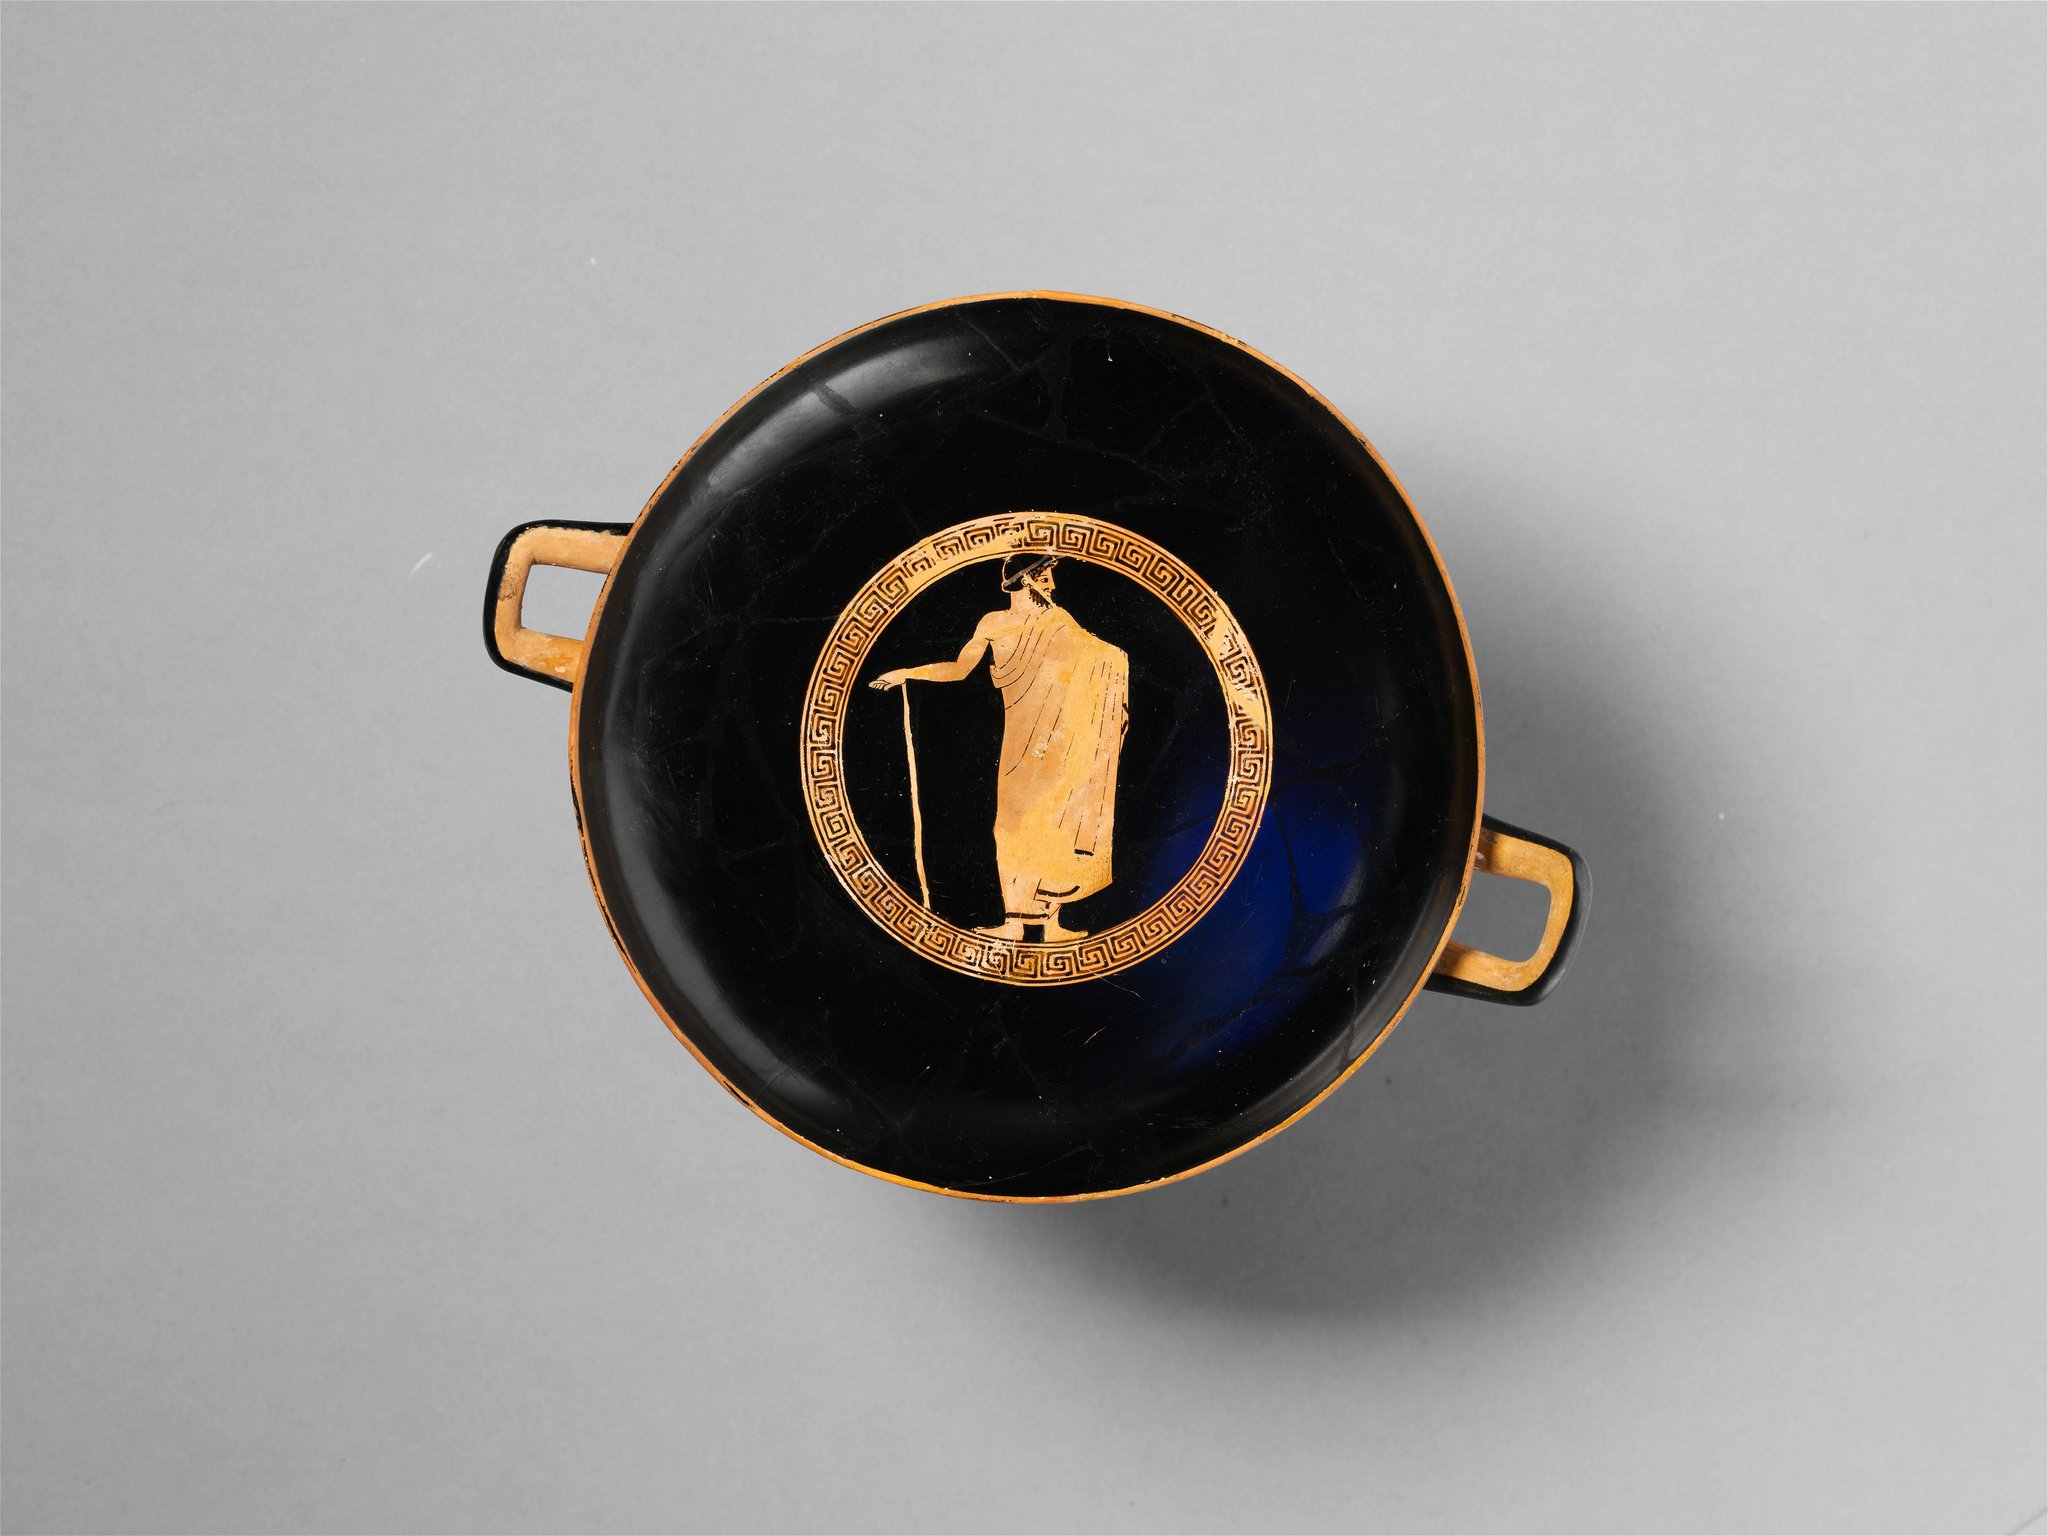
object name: kylix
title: Terracotta kylix (drinking cup)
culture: greek, attic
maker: makron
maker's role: artist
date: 467-435 BCE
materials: terracotta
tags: men